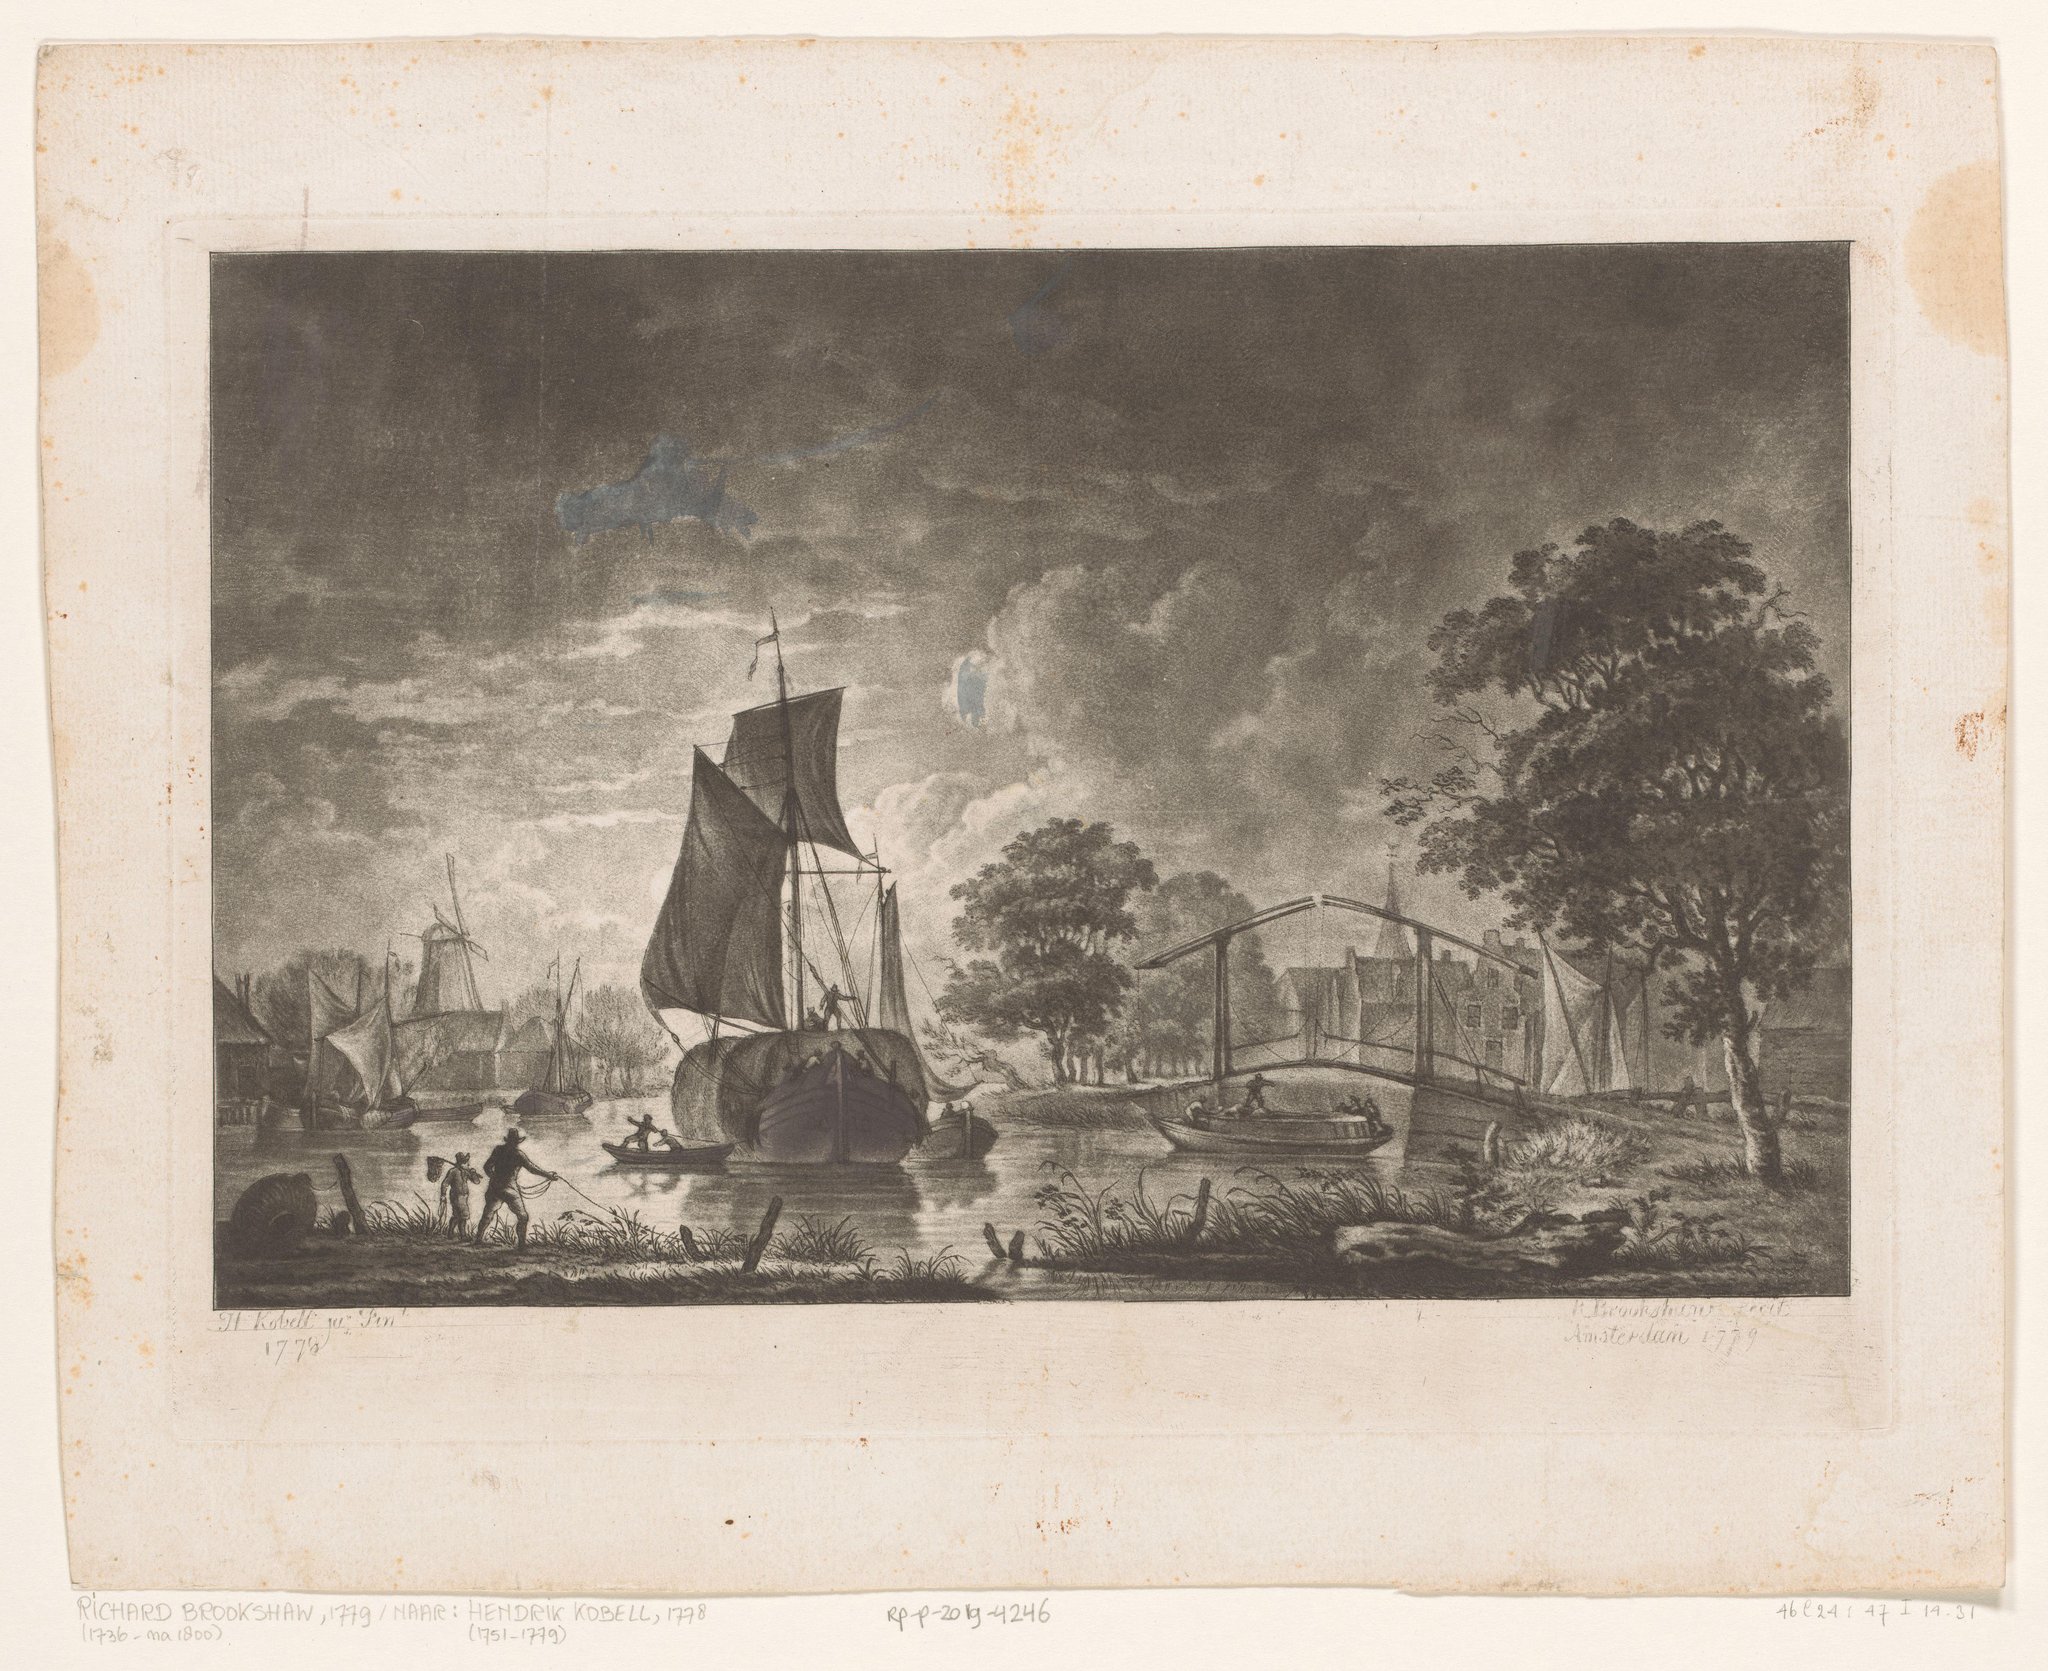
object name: print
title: Gezicht op de Heimanswetering en Molenaarsbrug te Alphen aan den Rijn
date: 1779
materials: paper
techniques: etching, hand coloring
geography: amsterdam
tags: sailing-ship, sailing-boat, windmill in landscape, bridge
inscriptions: collector's mark: Lugt 2228